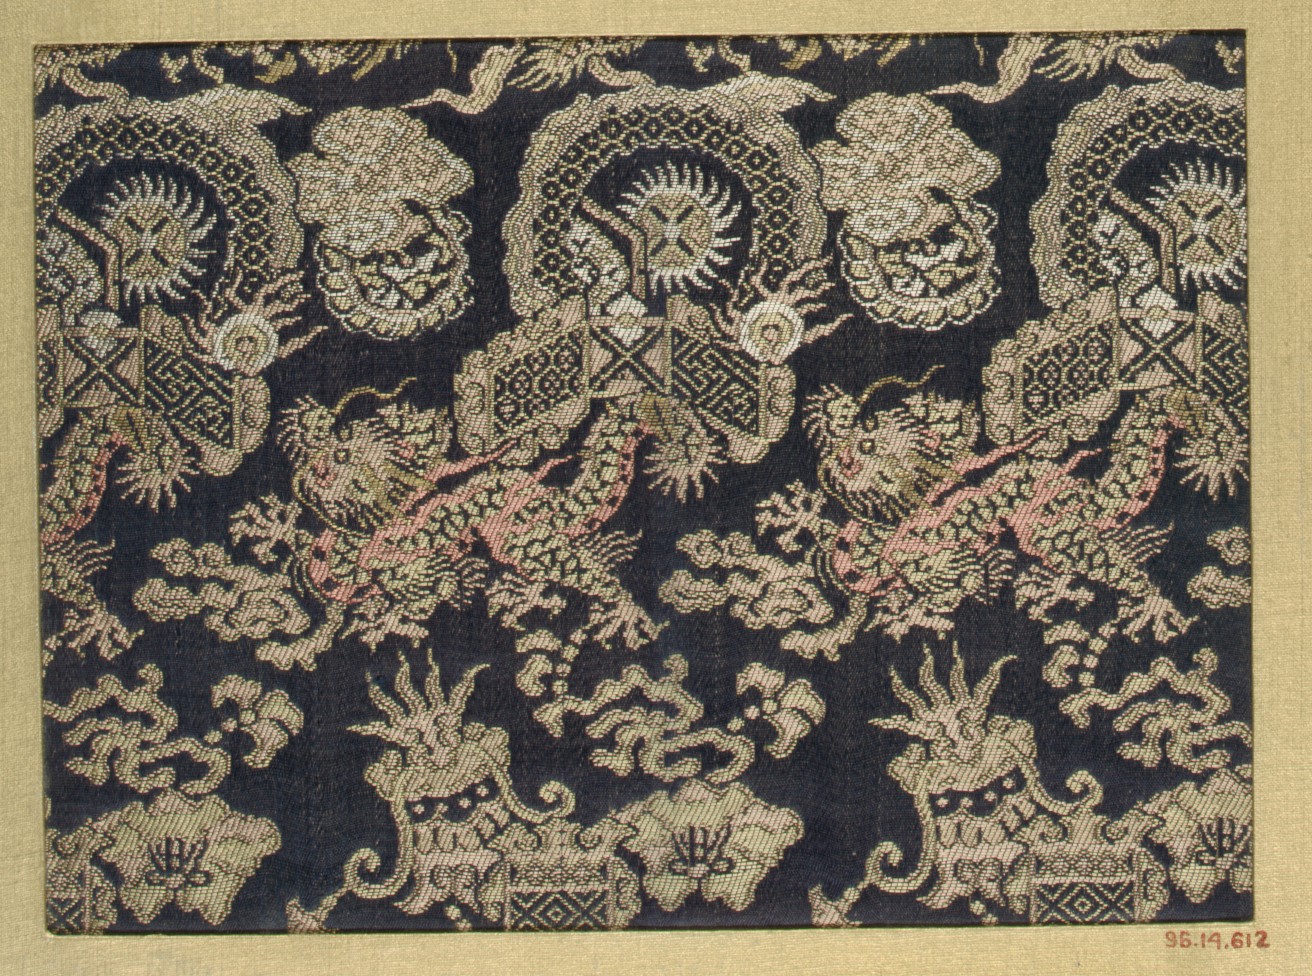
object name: piece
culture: japanese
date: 1701-1900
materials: silk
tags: dragons